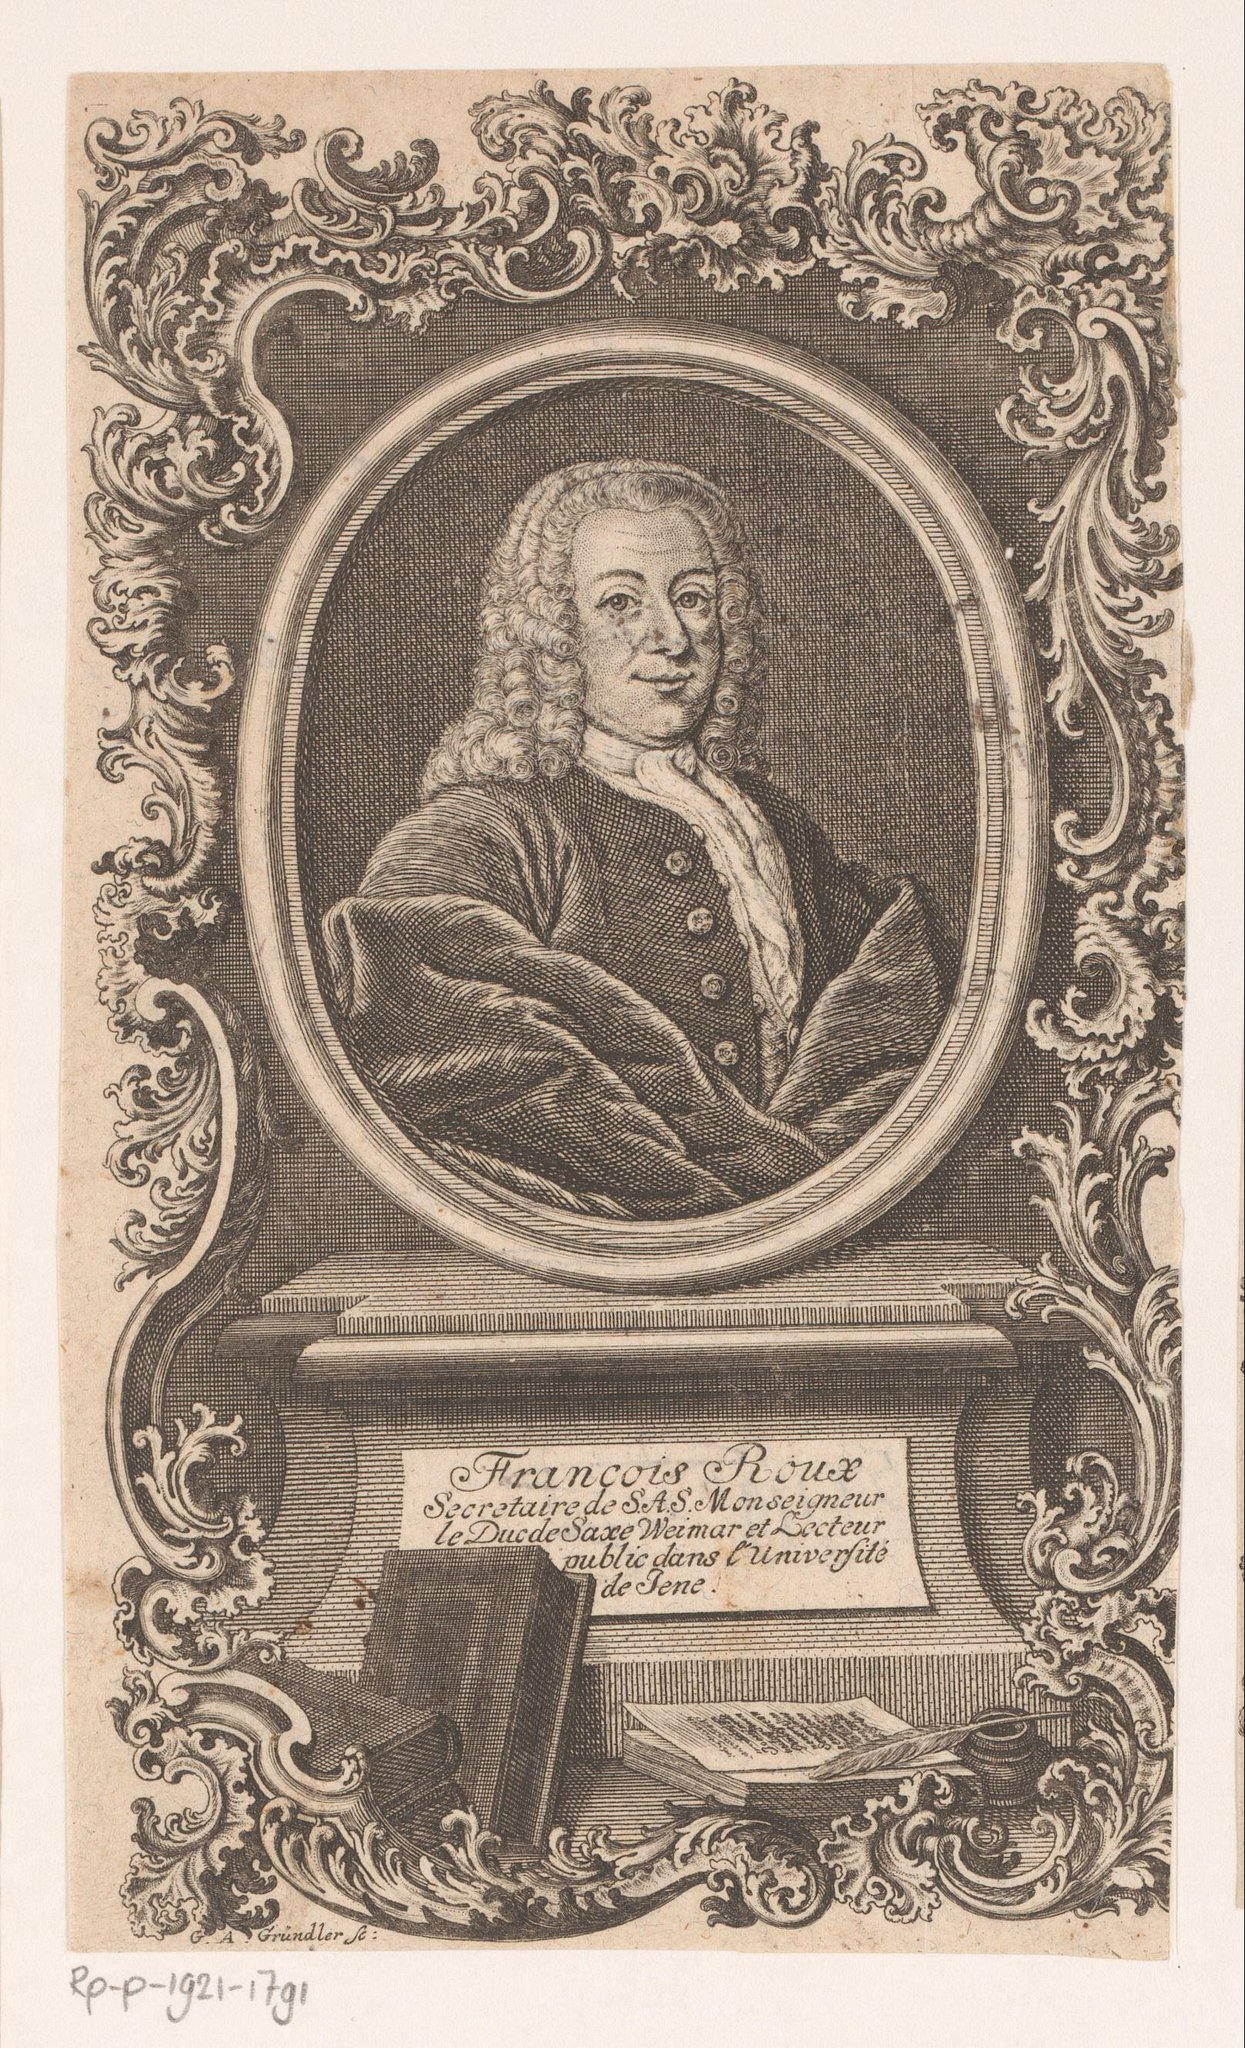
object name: print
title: Portret van François Roux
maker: gottfried august gründler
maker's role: painter, print maker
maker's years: 1710-1775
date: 1720-1750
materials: paper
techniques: engraving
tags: rocaille ornament, writing tools, ornament ~ medallion, historical persons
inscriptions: collector's mark: Lugt 2233, inscription